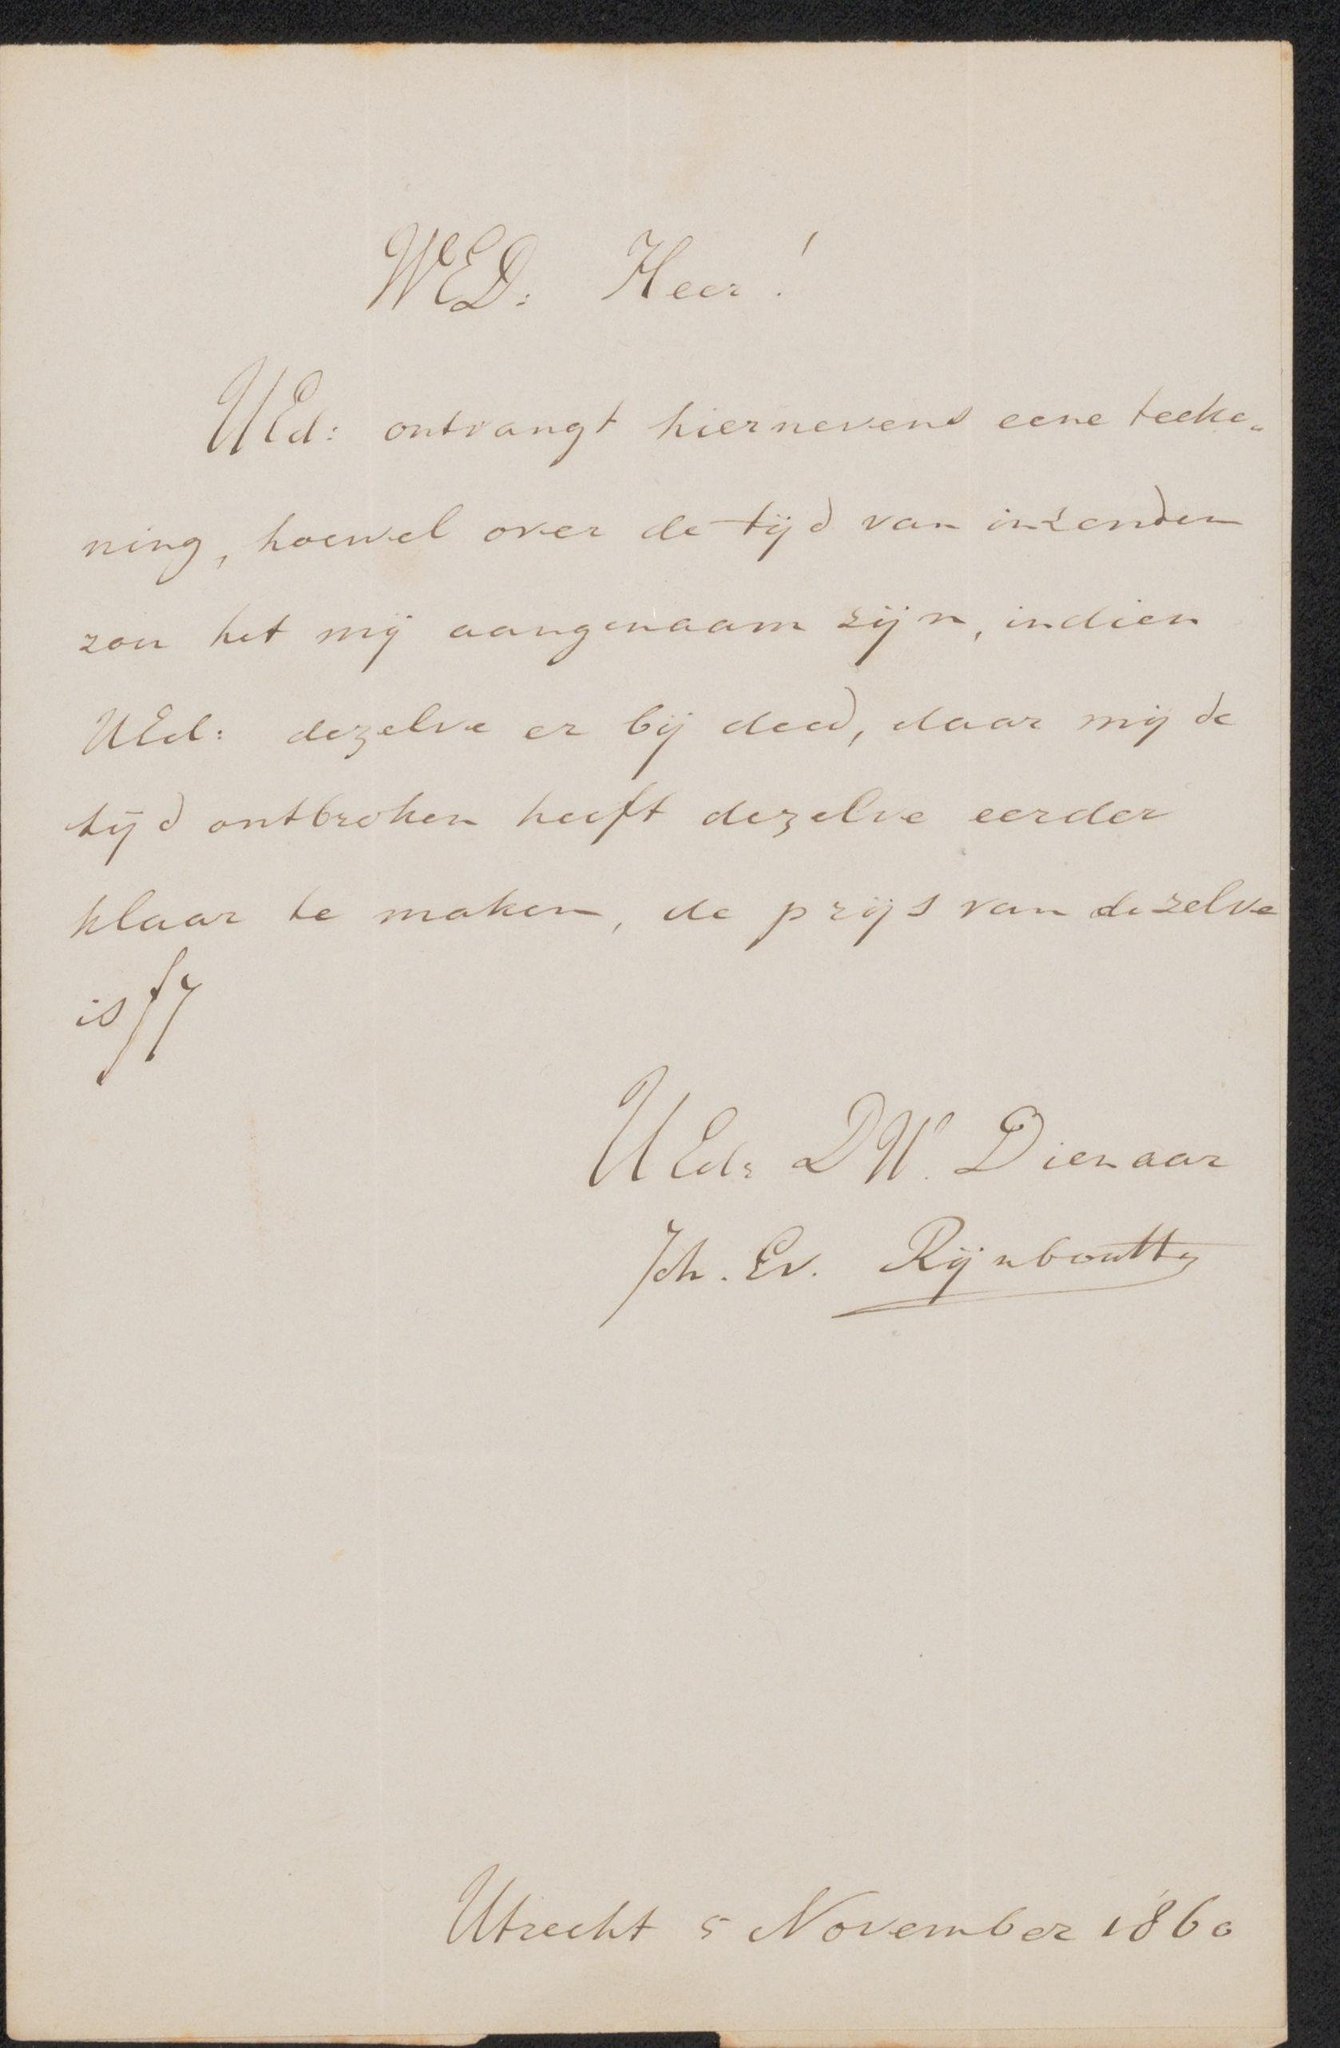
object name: letter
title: Brief aan Pieter Verloren van Themaat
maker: johannes everhardus rijnboutt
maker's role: print maker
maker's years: 1839-1900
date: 1860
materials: ink, paper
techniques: pen, writing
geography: utrecht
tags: pieter verloren van themaat, drawing, money